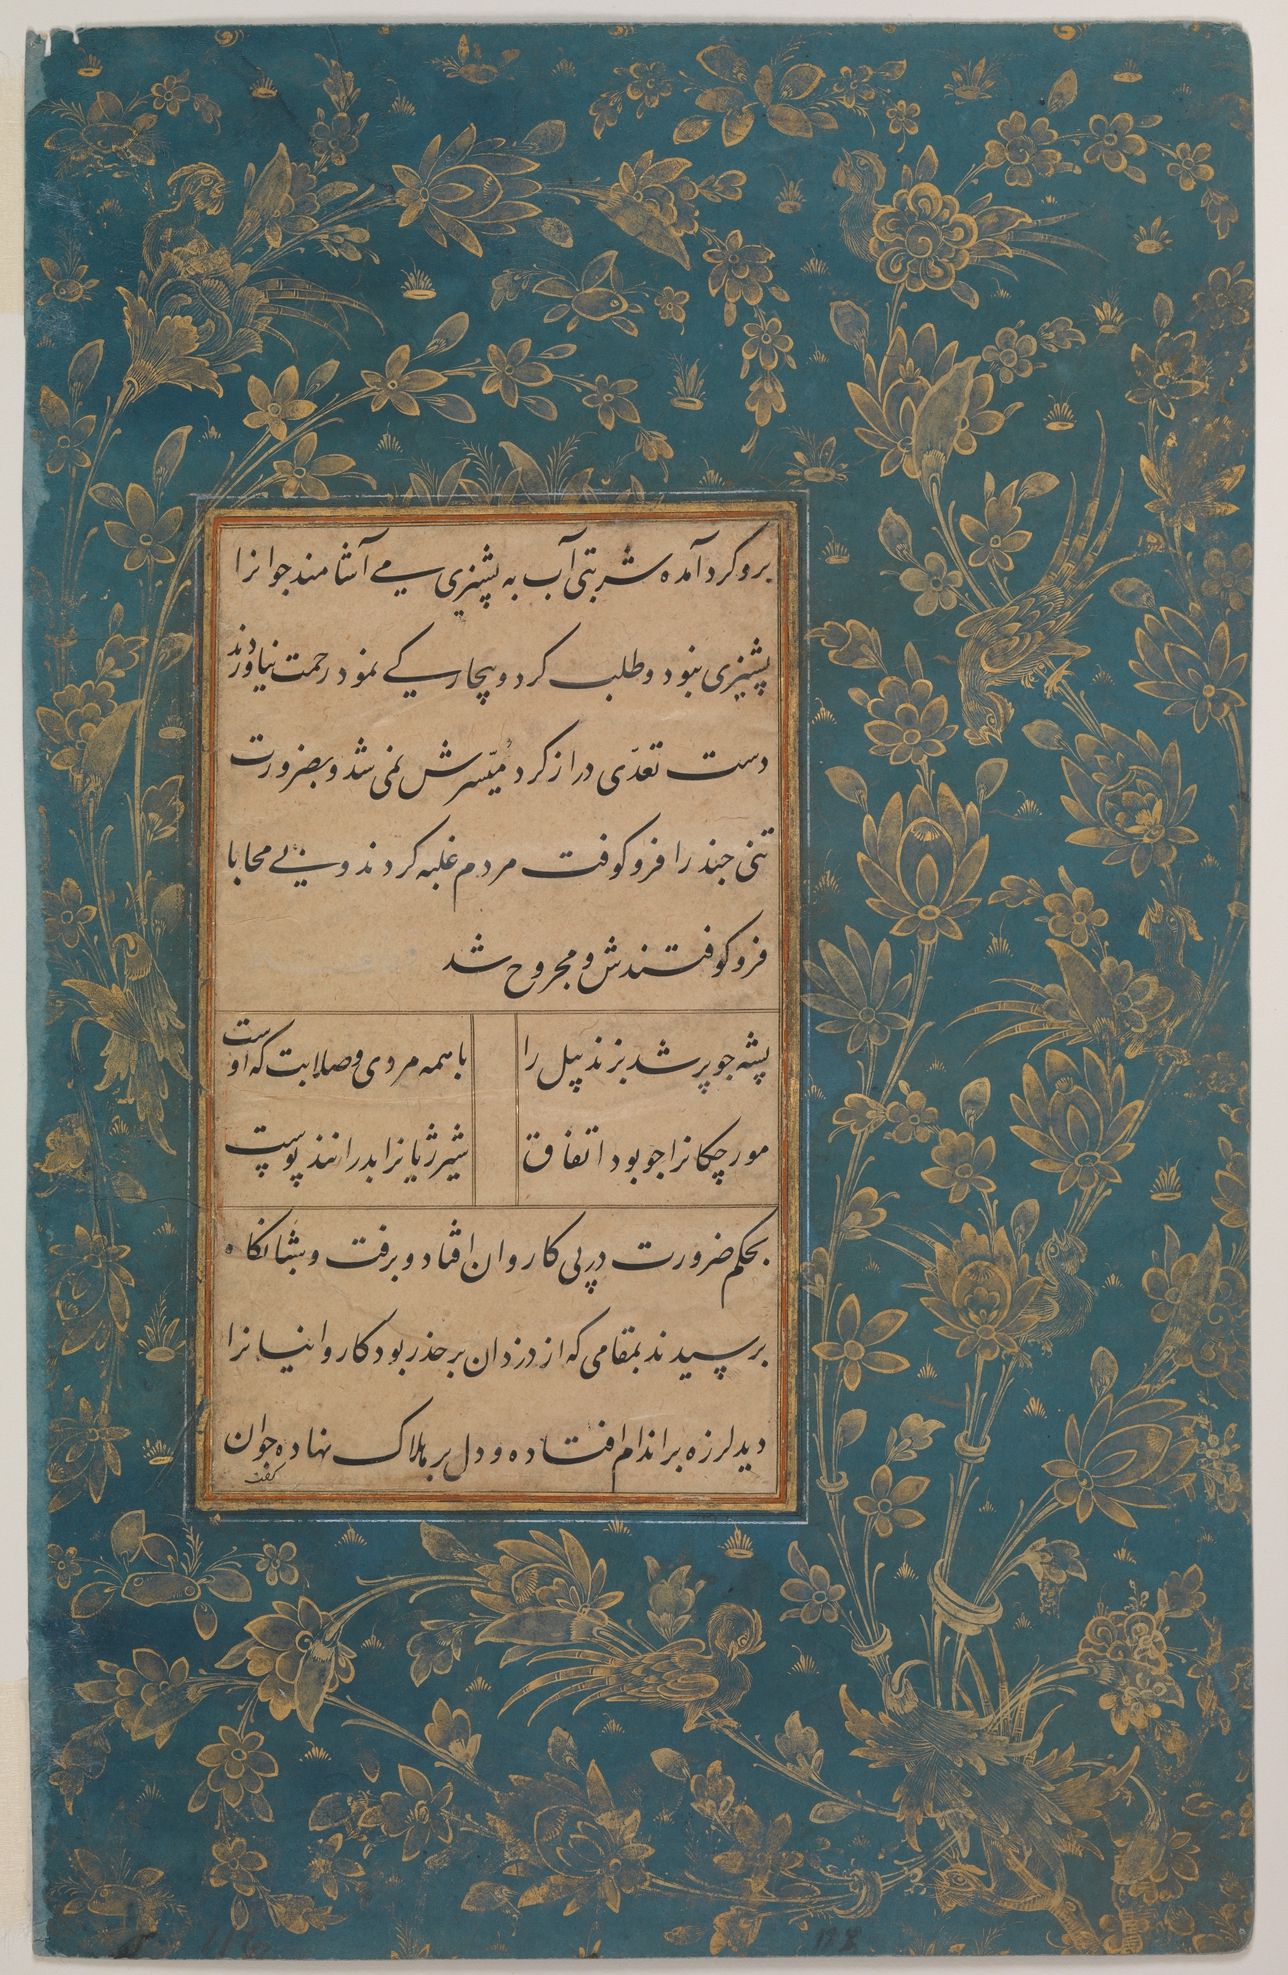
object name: folio from a non illustrated manuscript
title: Page of Calligraphy from an Anthology of Poetry by Sa`di and Hafiz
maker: sa'di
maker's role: author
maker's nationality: iranian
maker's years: 1213-1291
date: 1467-1500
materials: gold, ink, paper, silver, watercolor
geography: afghanistan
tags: birds,persian,flowers